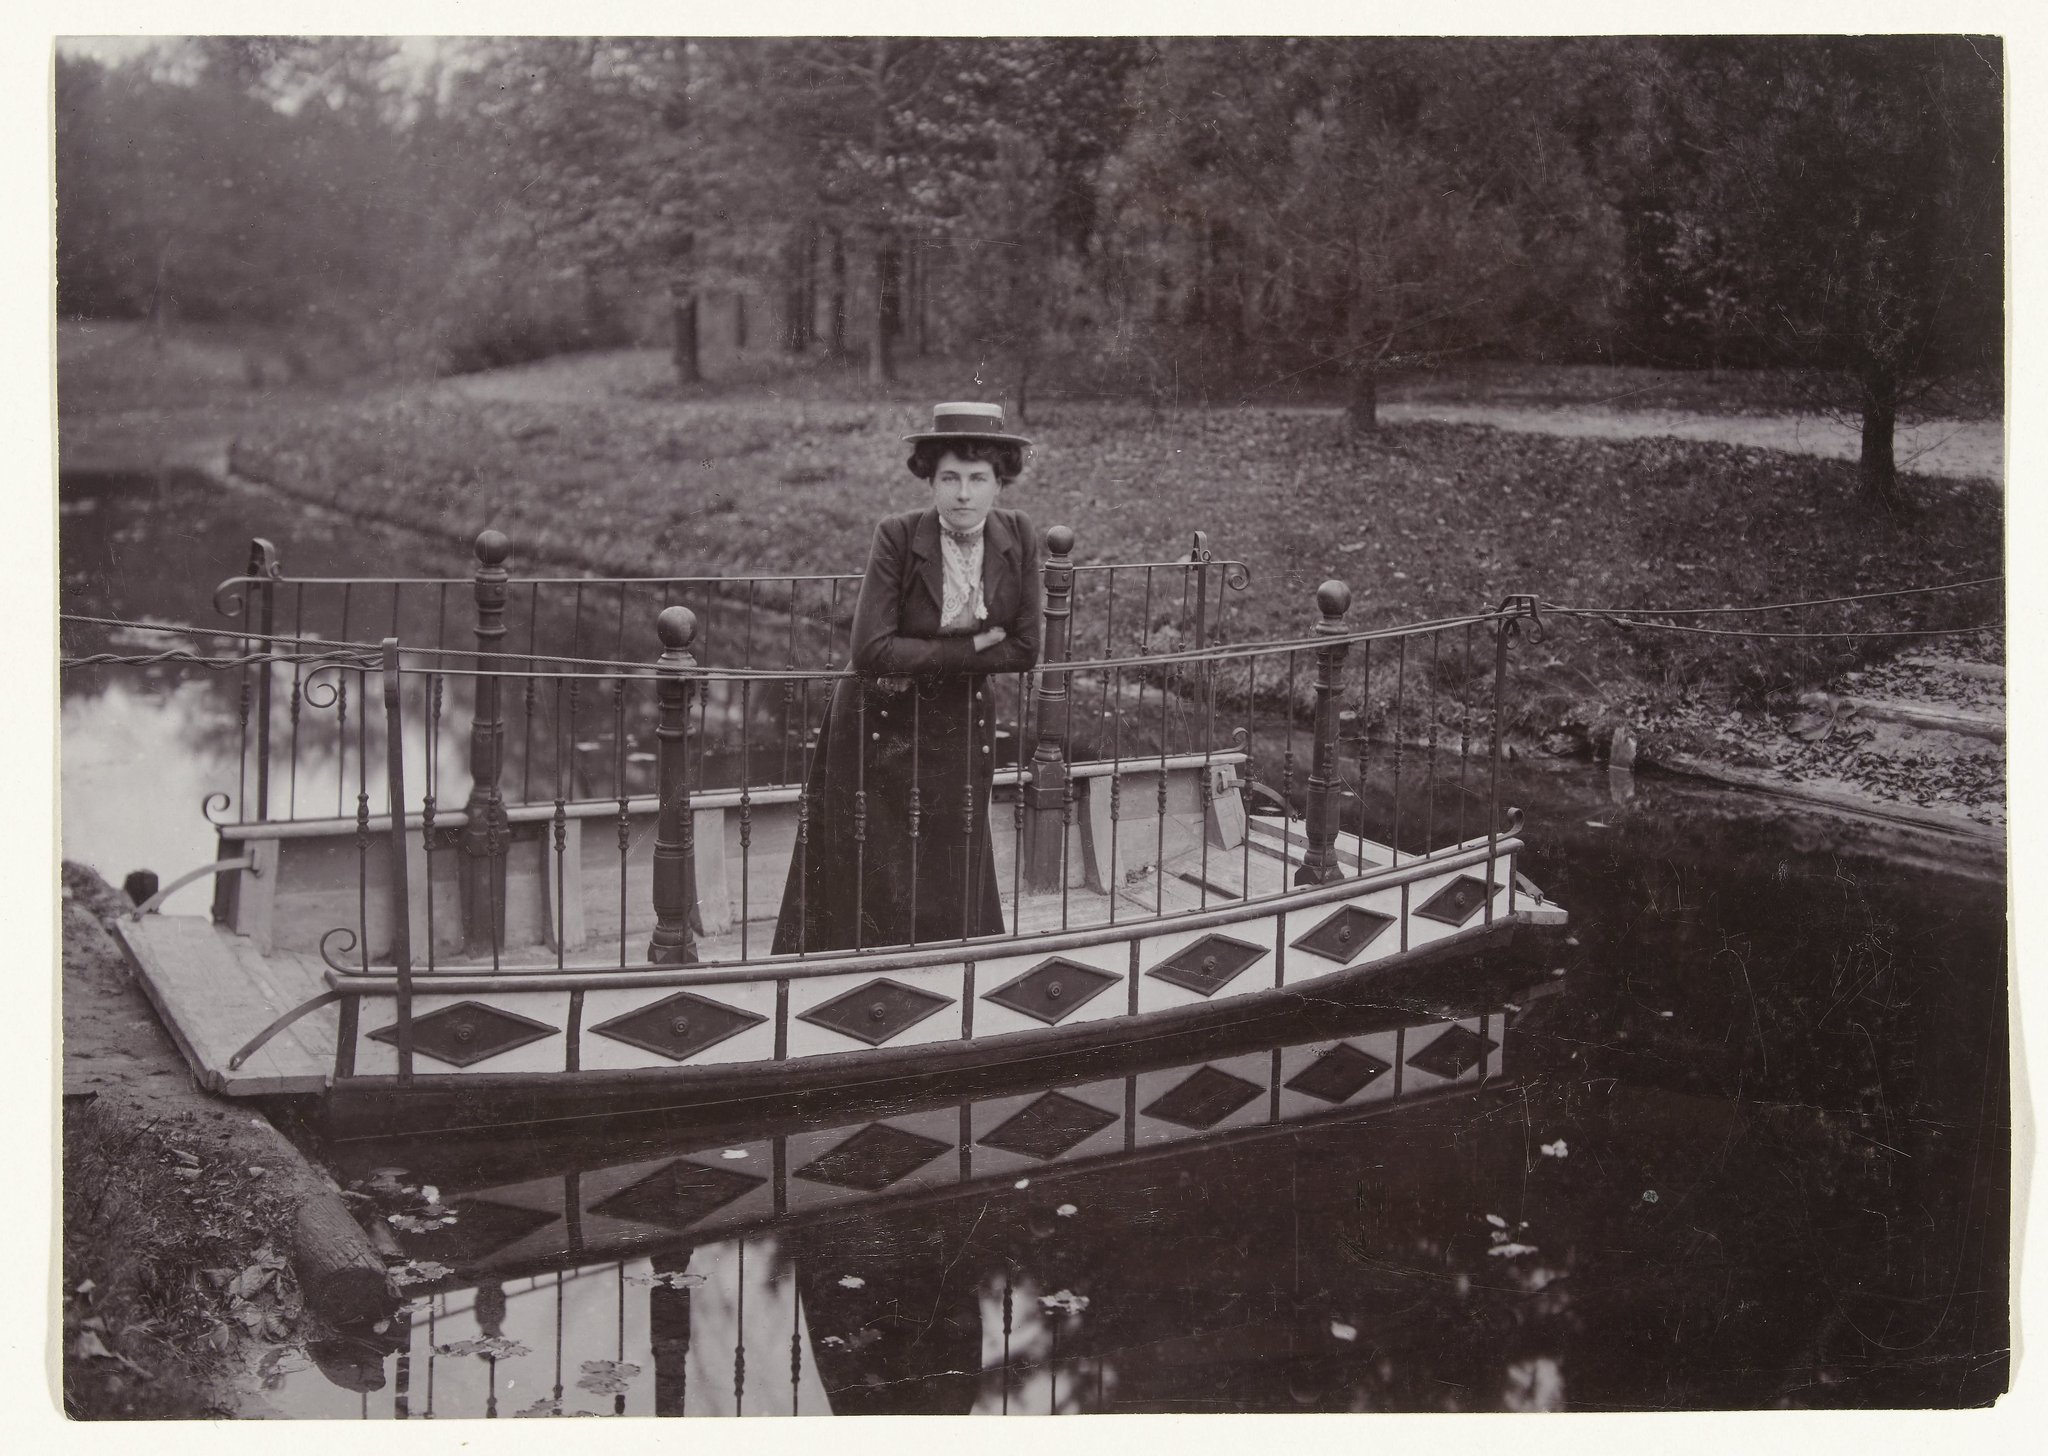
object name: photograph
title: Portret van Johanna Elisabeth ('Sissy') Pauw van Wieldrecht-Boissevain op een pontje op landgoed Pavia, Zeist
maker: henry pauw van wieldrecht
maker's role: fotograaf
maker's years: 1863-1912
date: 1902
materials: cardboard, photographic support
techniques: collodion silver print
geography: zeist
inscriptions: annotation: ‘Sissy Boissevain Pauw / 1902 / Ze is in dat / jaar getrouwf / "Pavia" Zeist / 1902’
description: Johanna Elisabeth Boissevain (Amsterdam 2 juli 1874-Den Haag 10 april 1959), dochter van Mijnhard Johannes Boissevain (20 december 1845-25 oktober 1917) en Johanna Juliana Hock (1846-1909), trouwde op 29 januari 1903 in Amersfoort met Henry Pauw van Wieldrecht, hertrouwde in 1923 met mr. Willem Henri Johan Blanckenhagen (1876-1950).